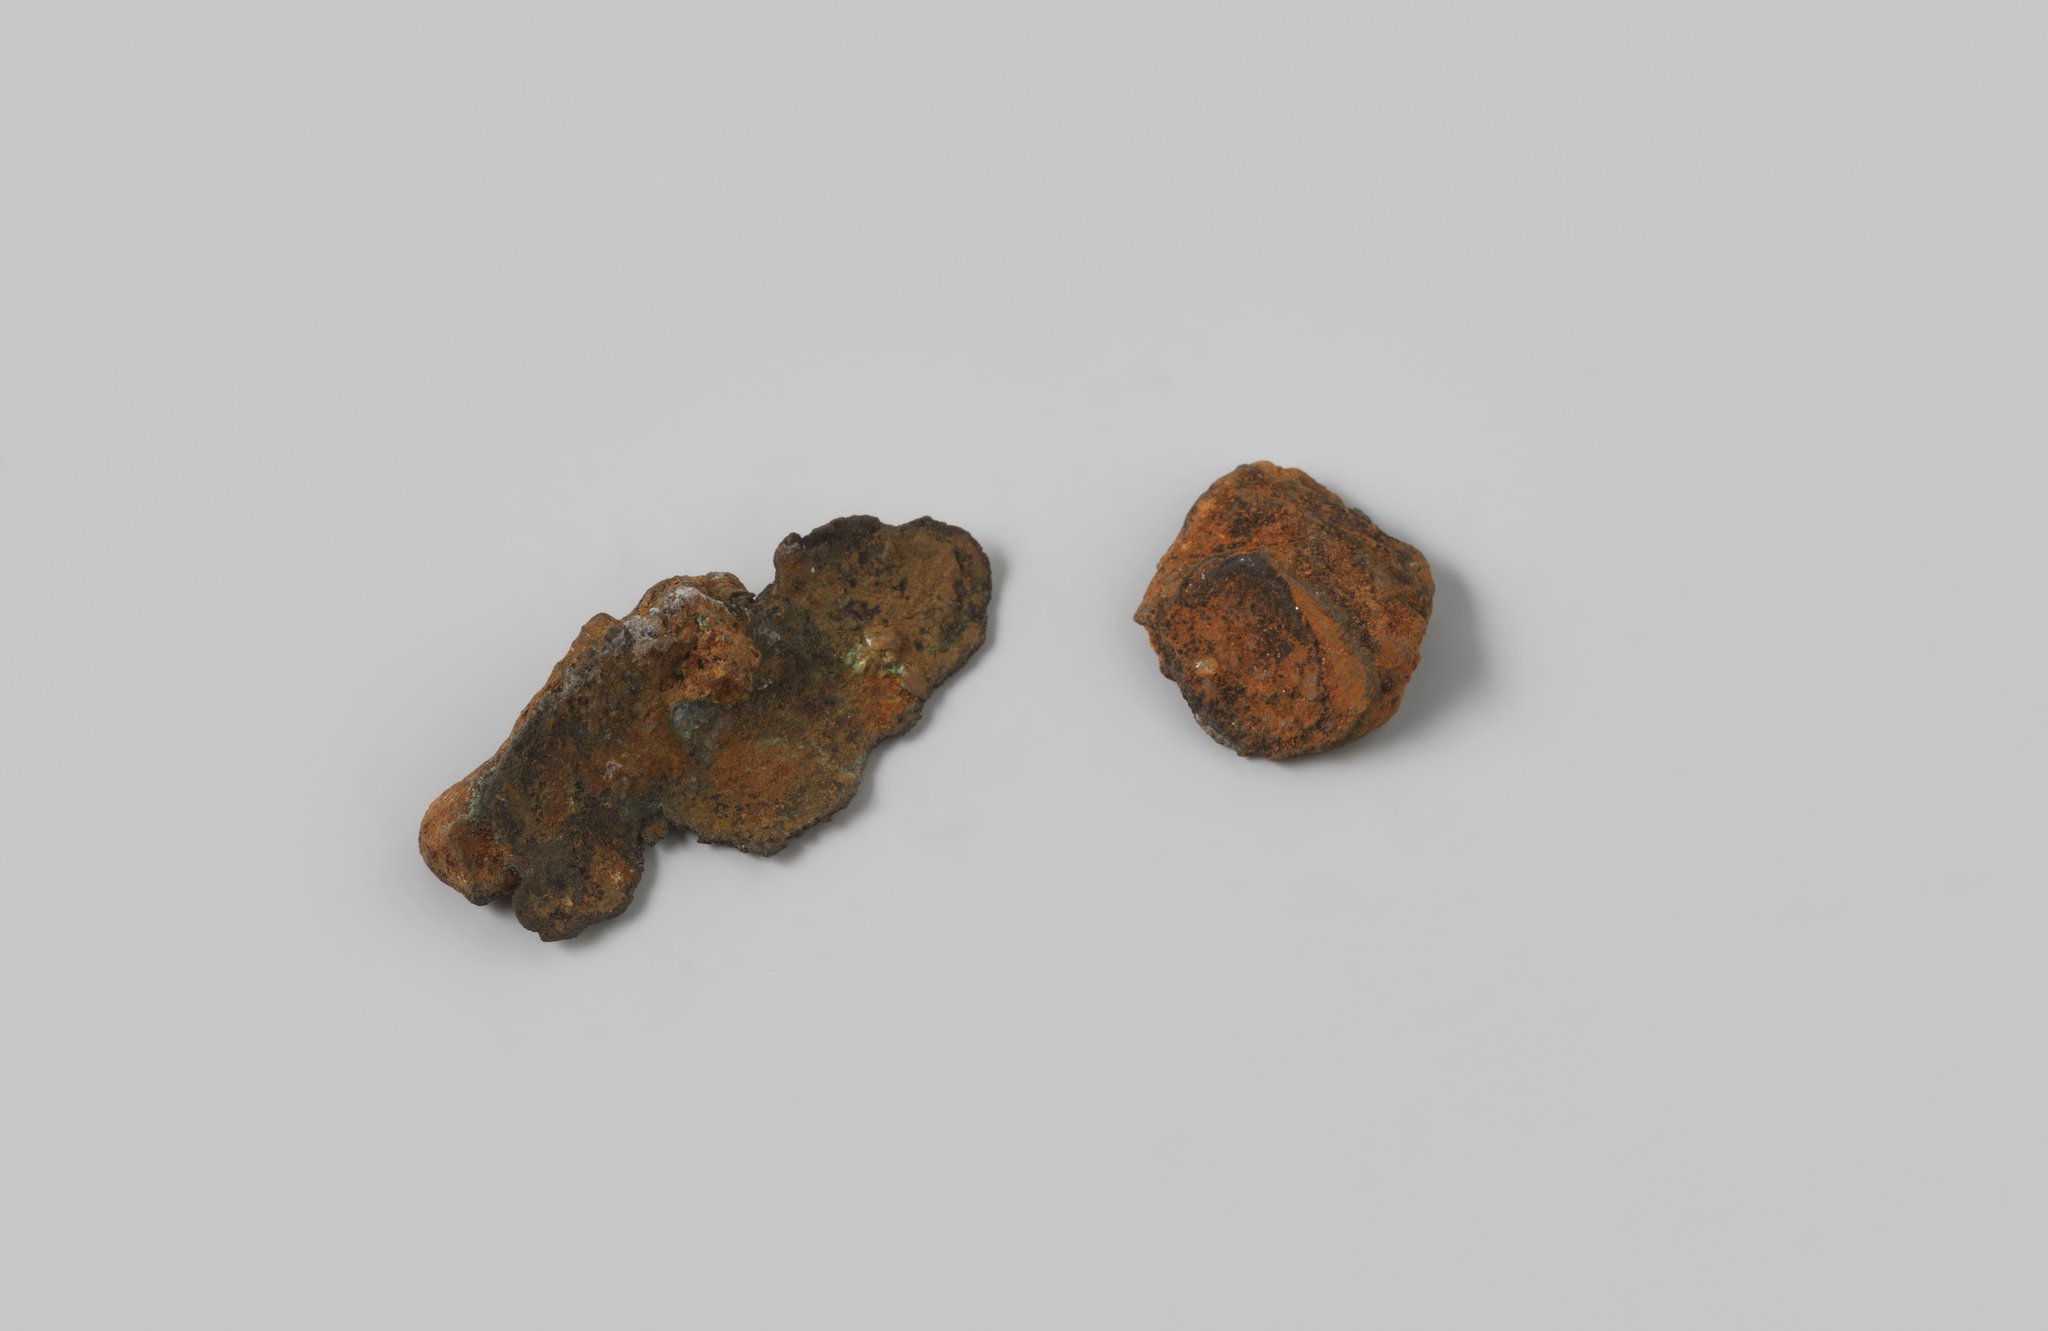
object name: cartridge shell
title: Patroonhuls en fragment beslag uit het wrak van de Oost-Indiëvaarder Hollandia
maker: Anonymous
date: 1700-1743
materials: copper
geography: netherlands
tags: verenigde oostindische compagnie, hollandia (schip), annet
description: Cartridge case, tube; fragm, eroded, id. NG 1979-205H549, with lead solder fragm.